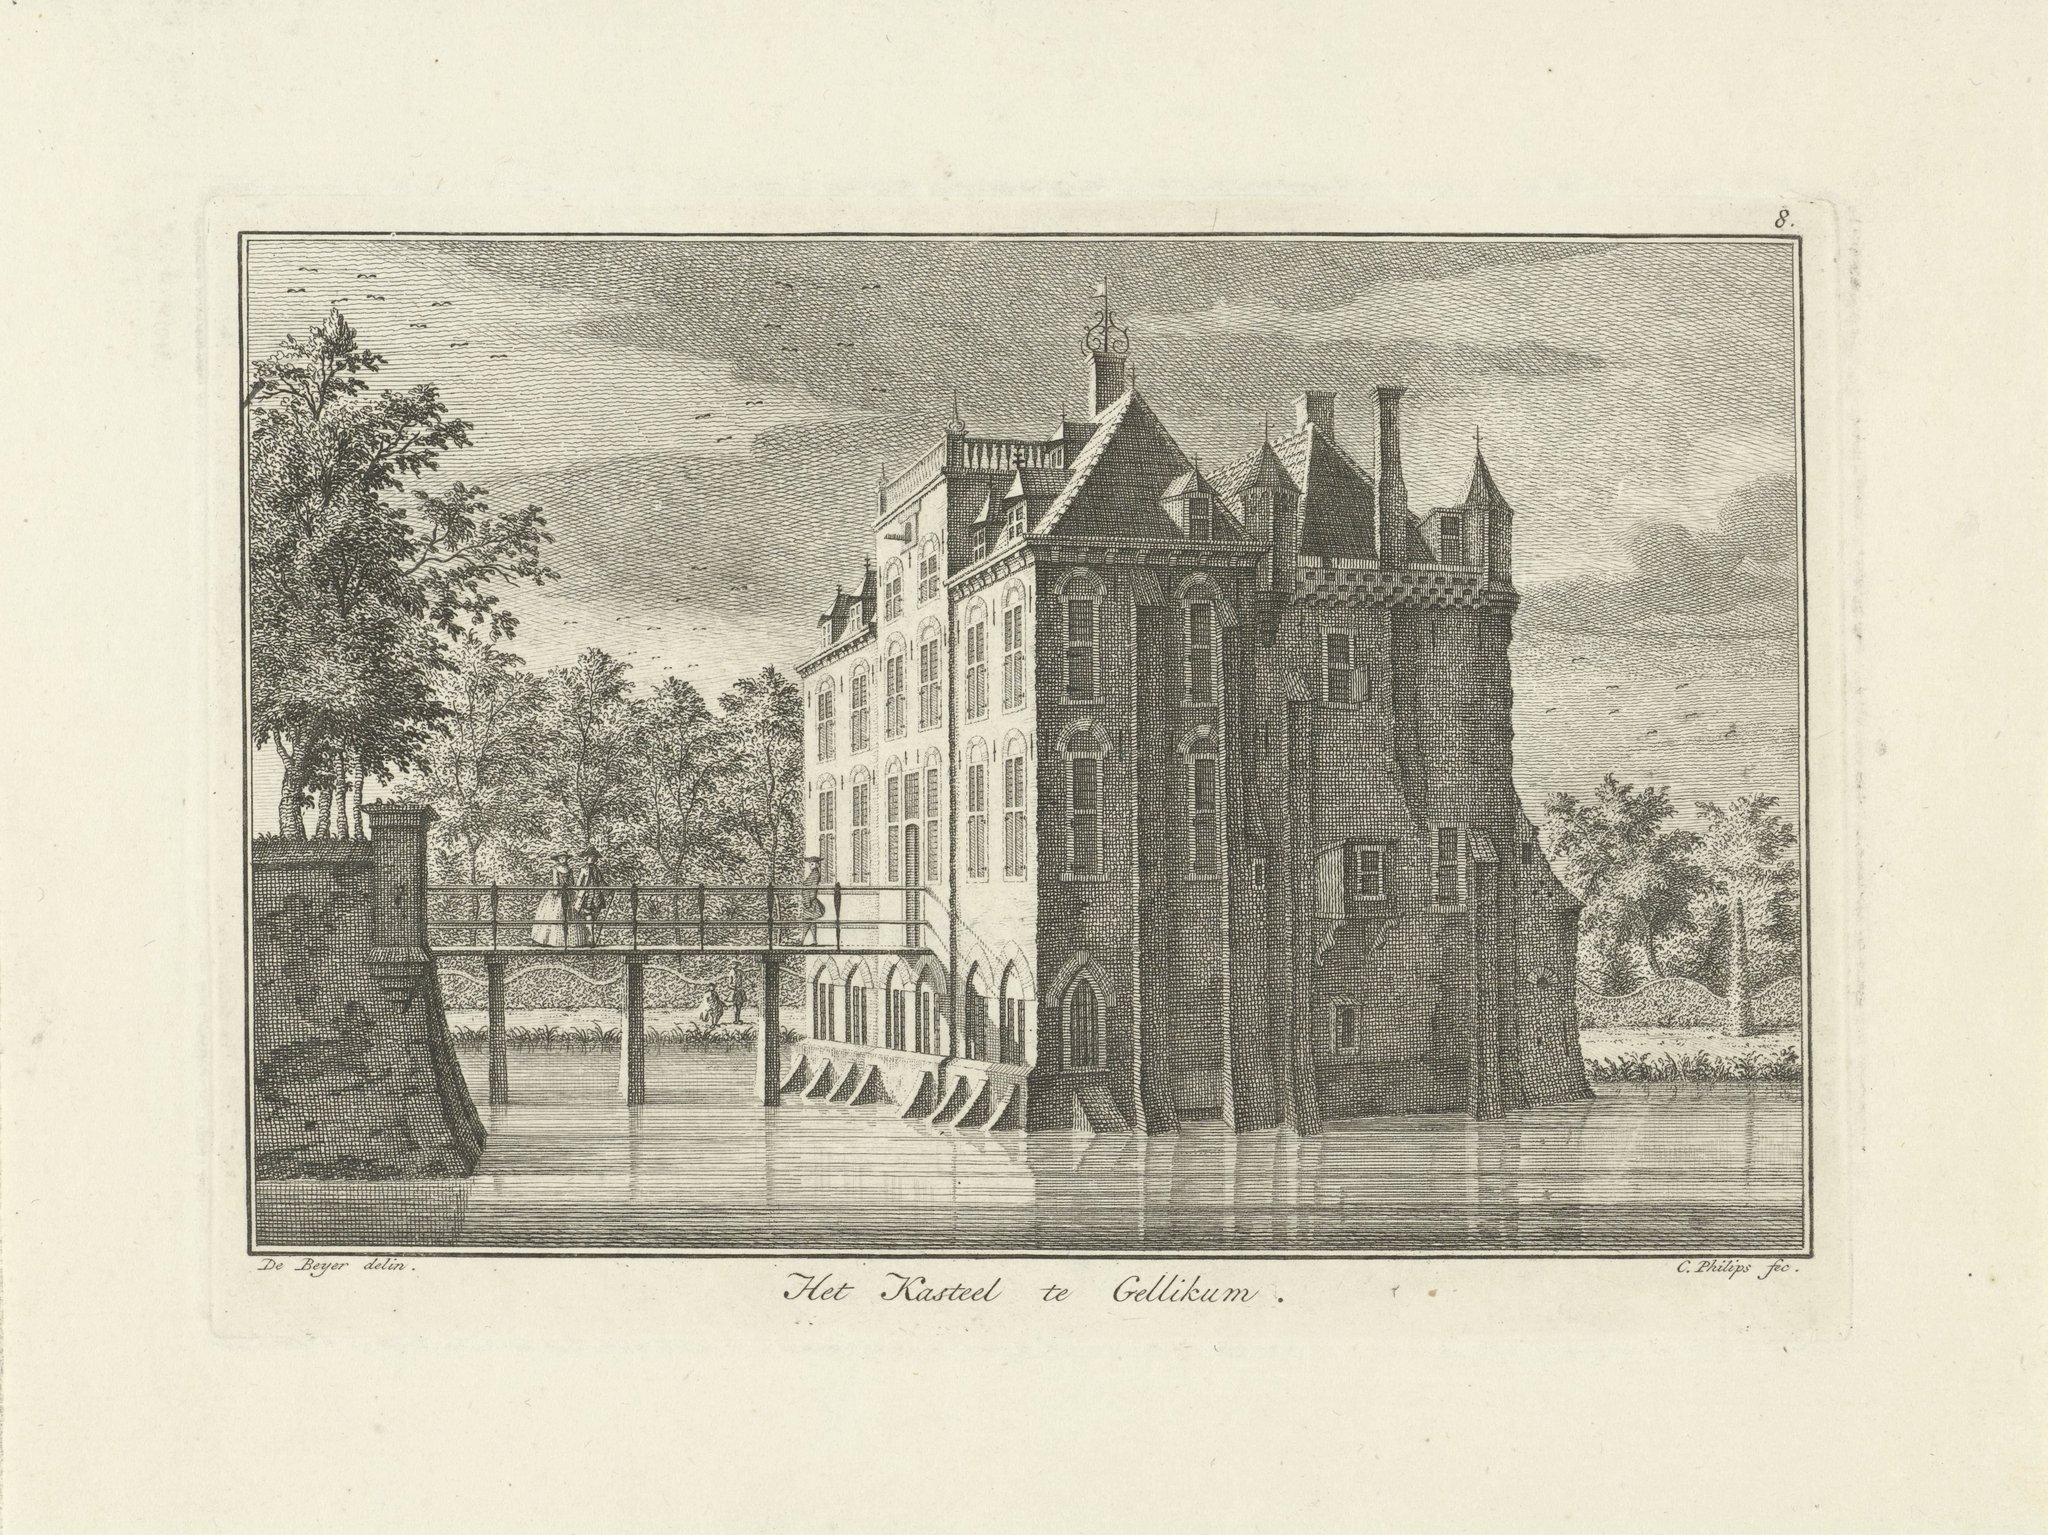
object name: print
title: Gezicht op het kasteel te Gellicum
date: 1752-1789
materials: paper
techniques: etching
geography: amsterdam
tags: castle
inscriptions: collector's mark: Lugt 2228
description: Gezicht op het kasteel te Gellicum en de slotgracht. Rechtsboven genummerd: 8.